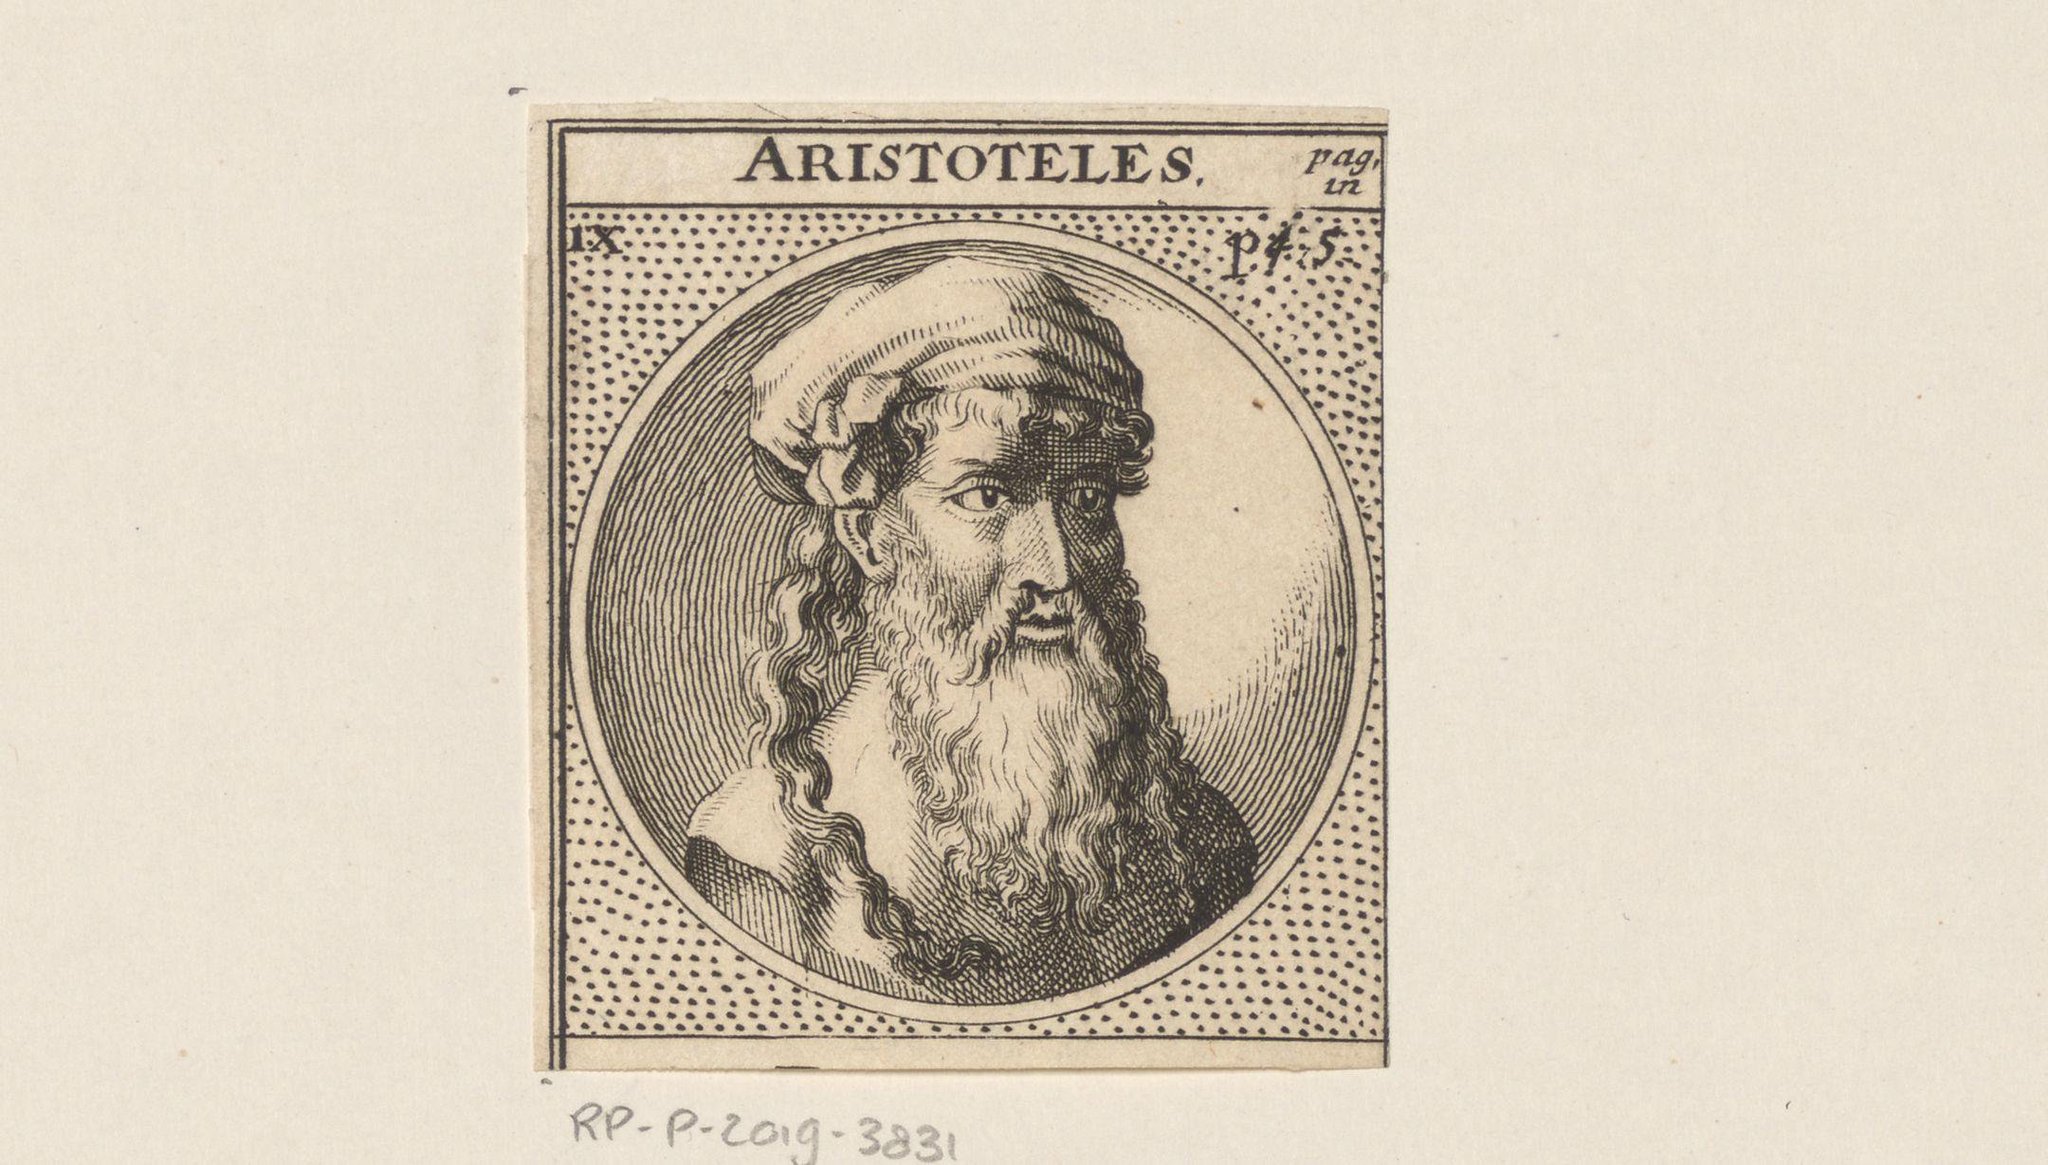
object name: print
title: Portret van Aristoteles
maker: Anonymous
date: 1700-1749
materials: paper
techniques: etching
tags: historical persons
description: Links- en rechtsboven genummerd: IX p. 45